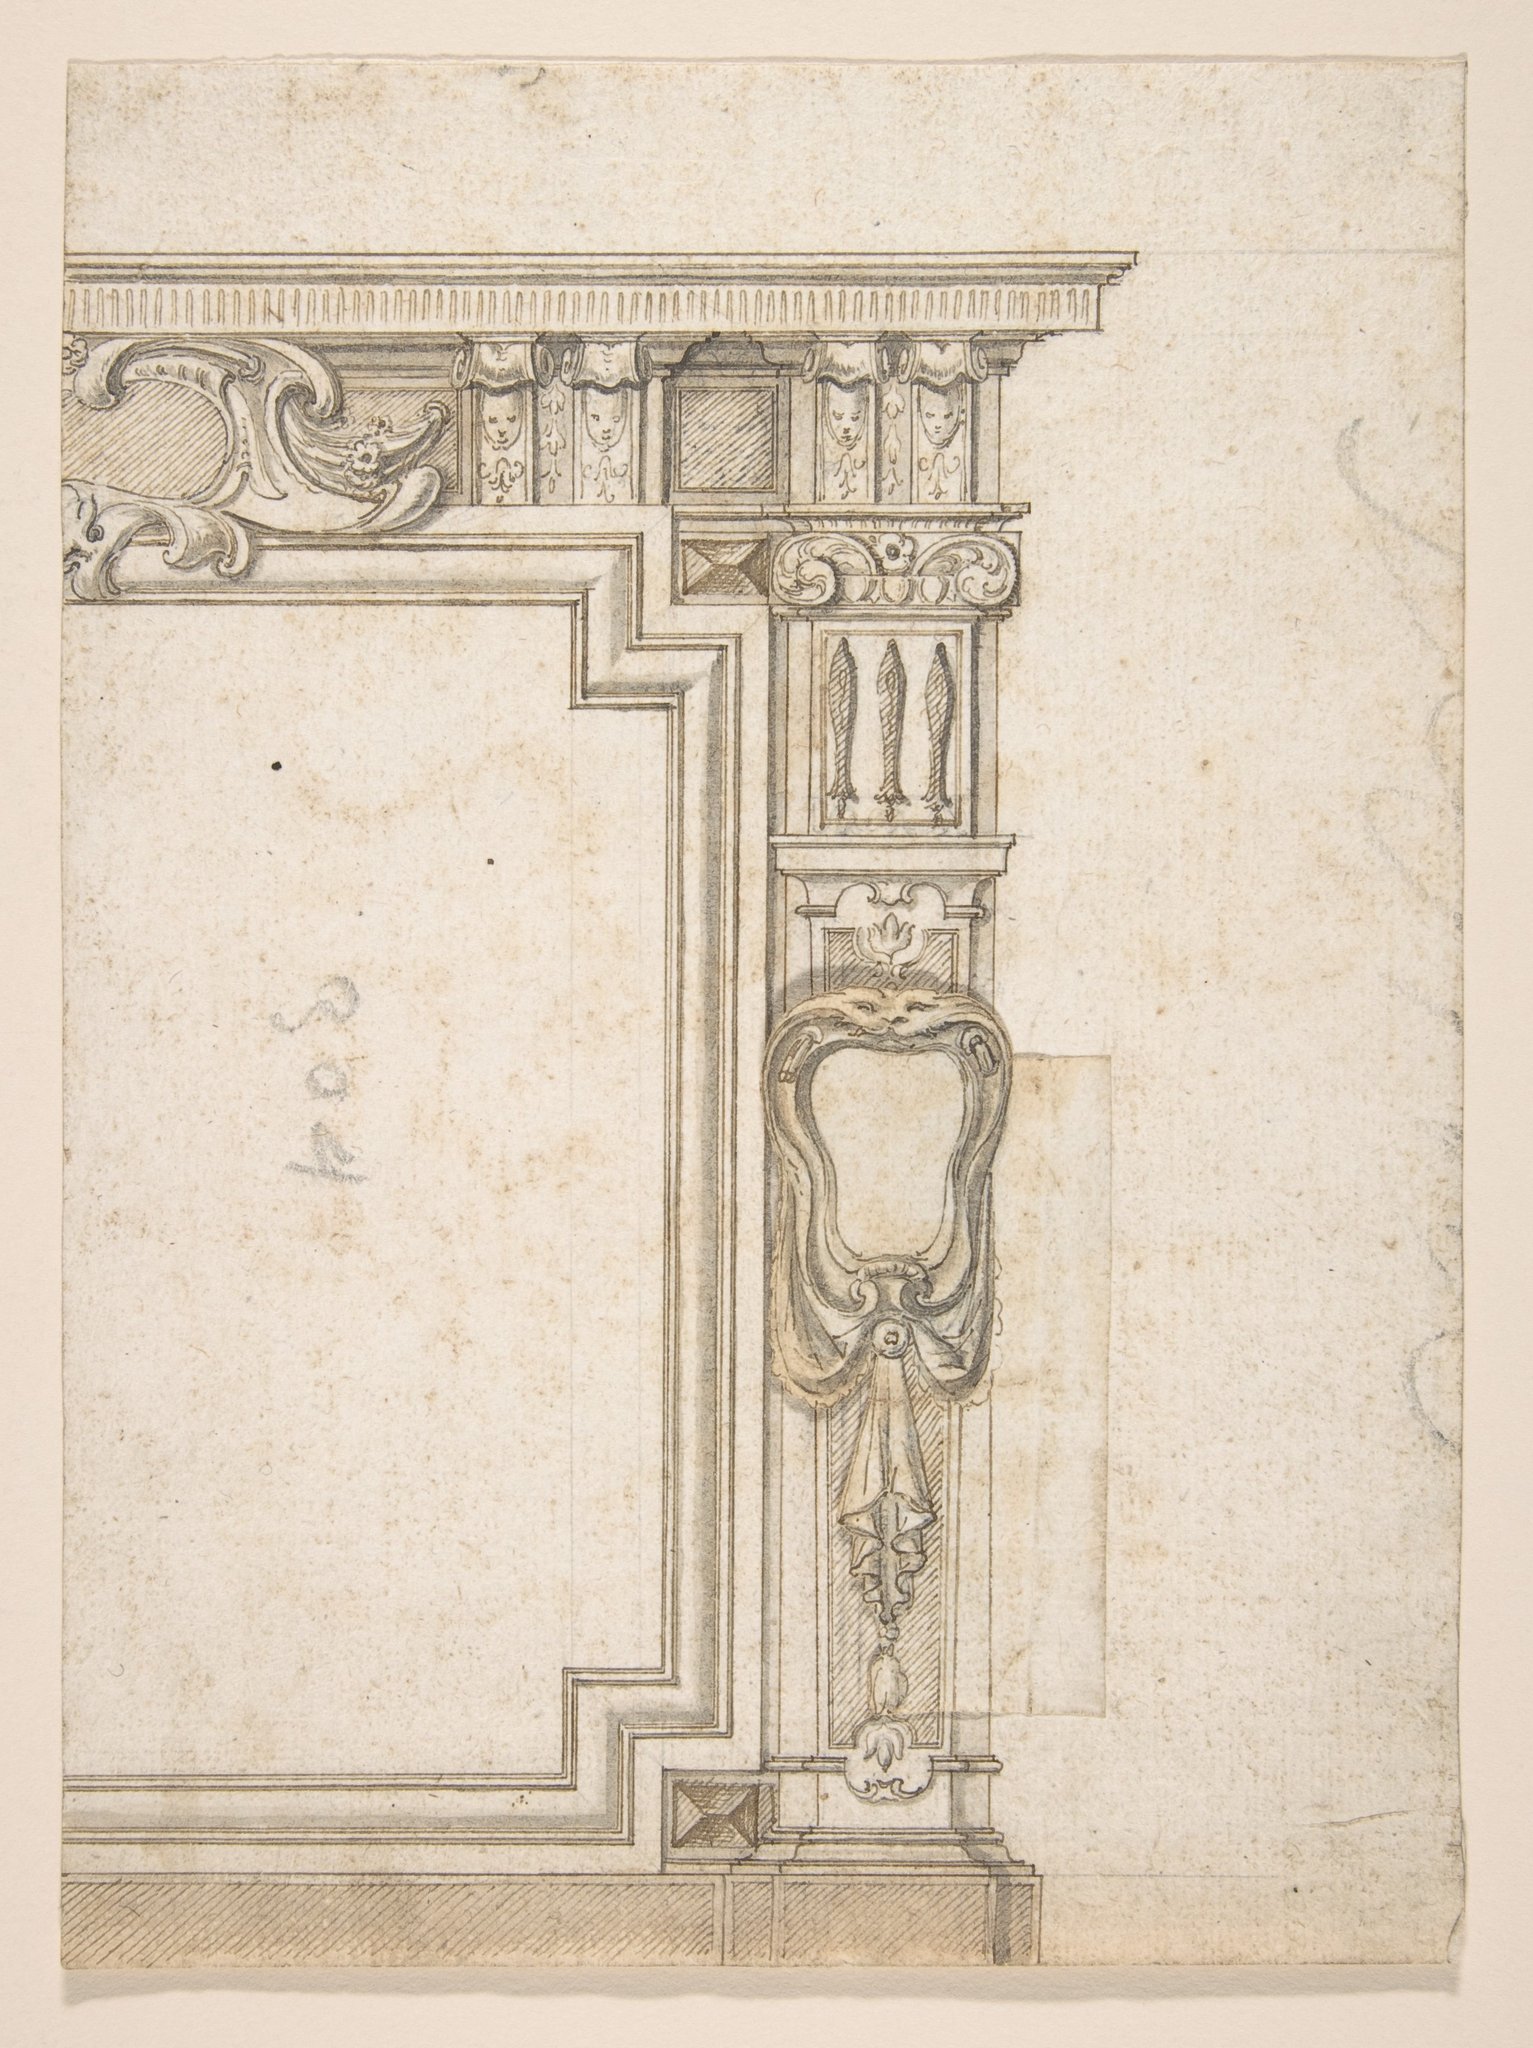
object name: drawing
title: Design for a Panel or a Tablet with an Alternate Design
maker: anonymous, french, 16th century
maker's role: artist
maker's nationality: french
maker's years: 1500-1600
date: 1501-1600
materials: ink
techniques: brush, pen, wash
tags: cartouches